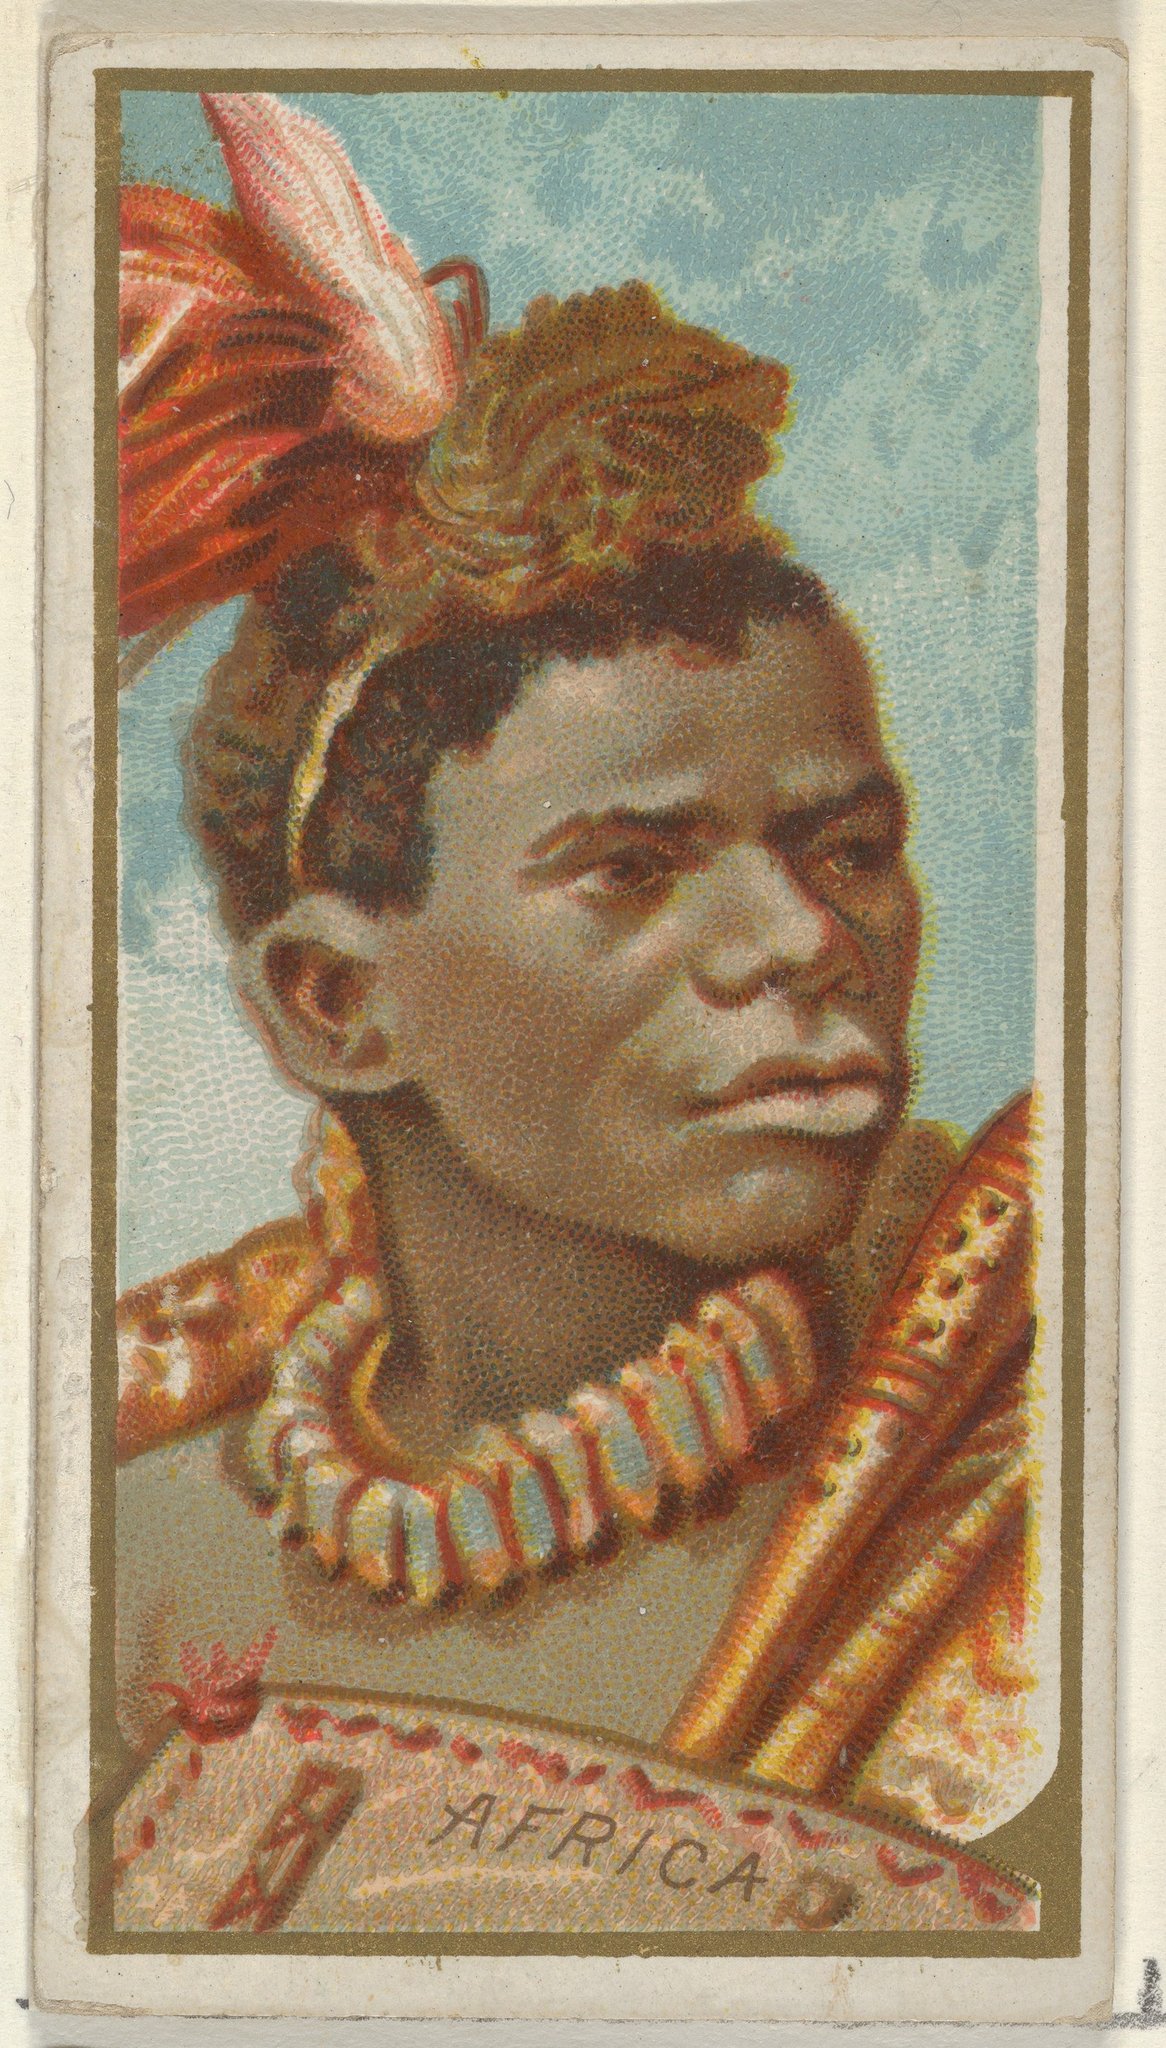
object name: print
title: Africa, from the Types of All Nations series (N24) for Allen & Ginter Cigarettes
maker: allen & ginter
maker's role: publisher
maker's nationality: american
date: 1889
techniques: color lithograph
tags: men